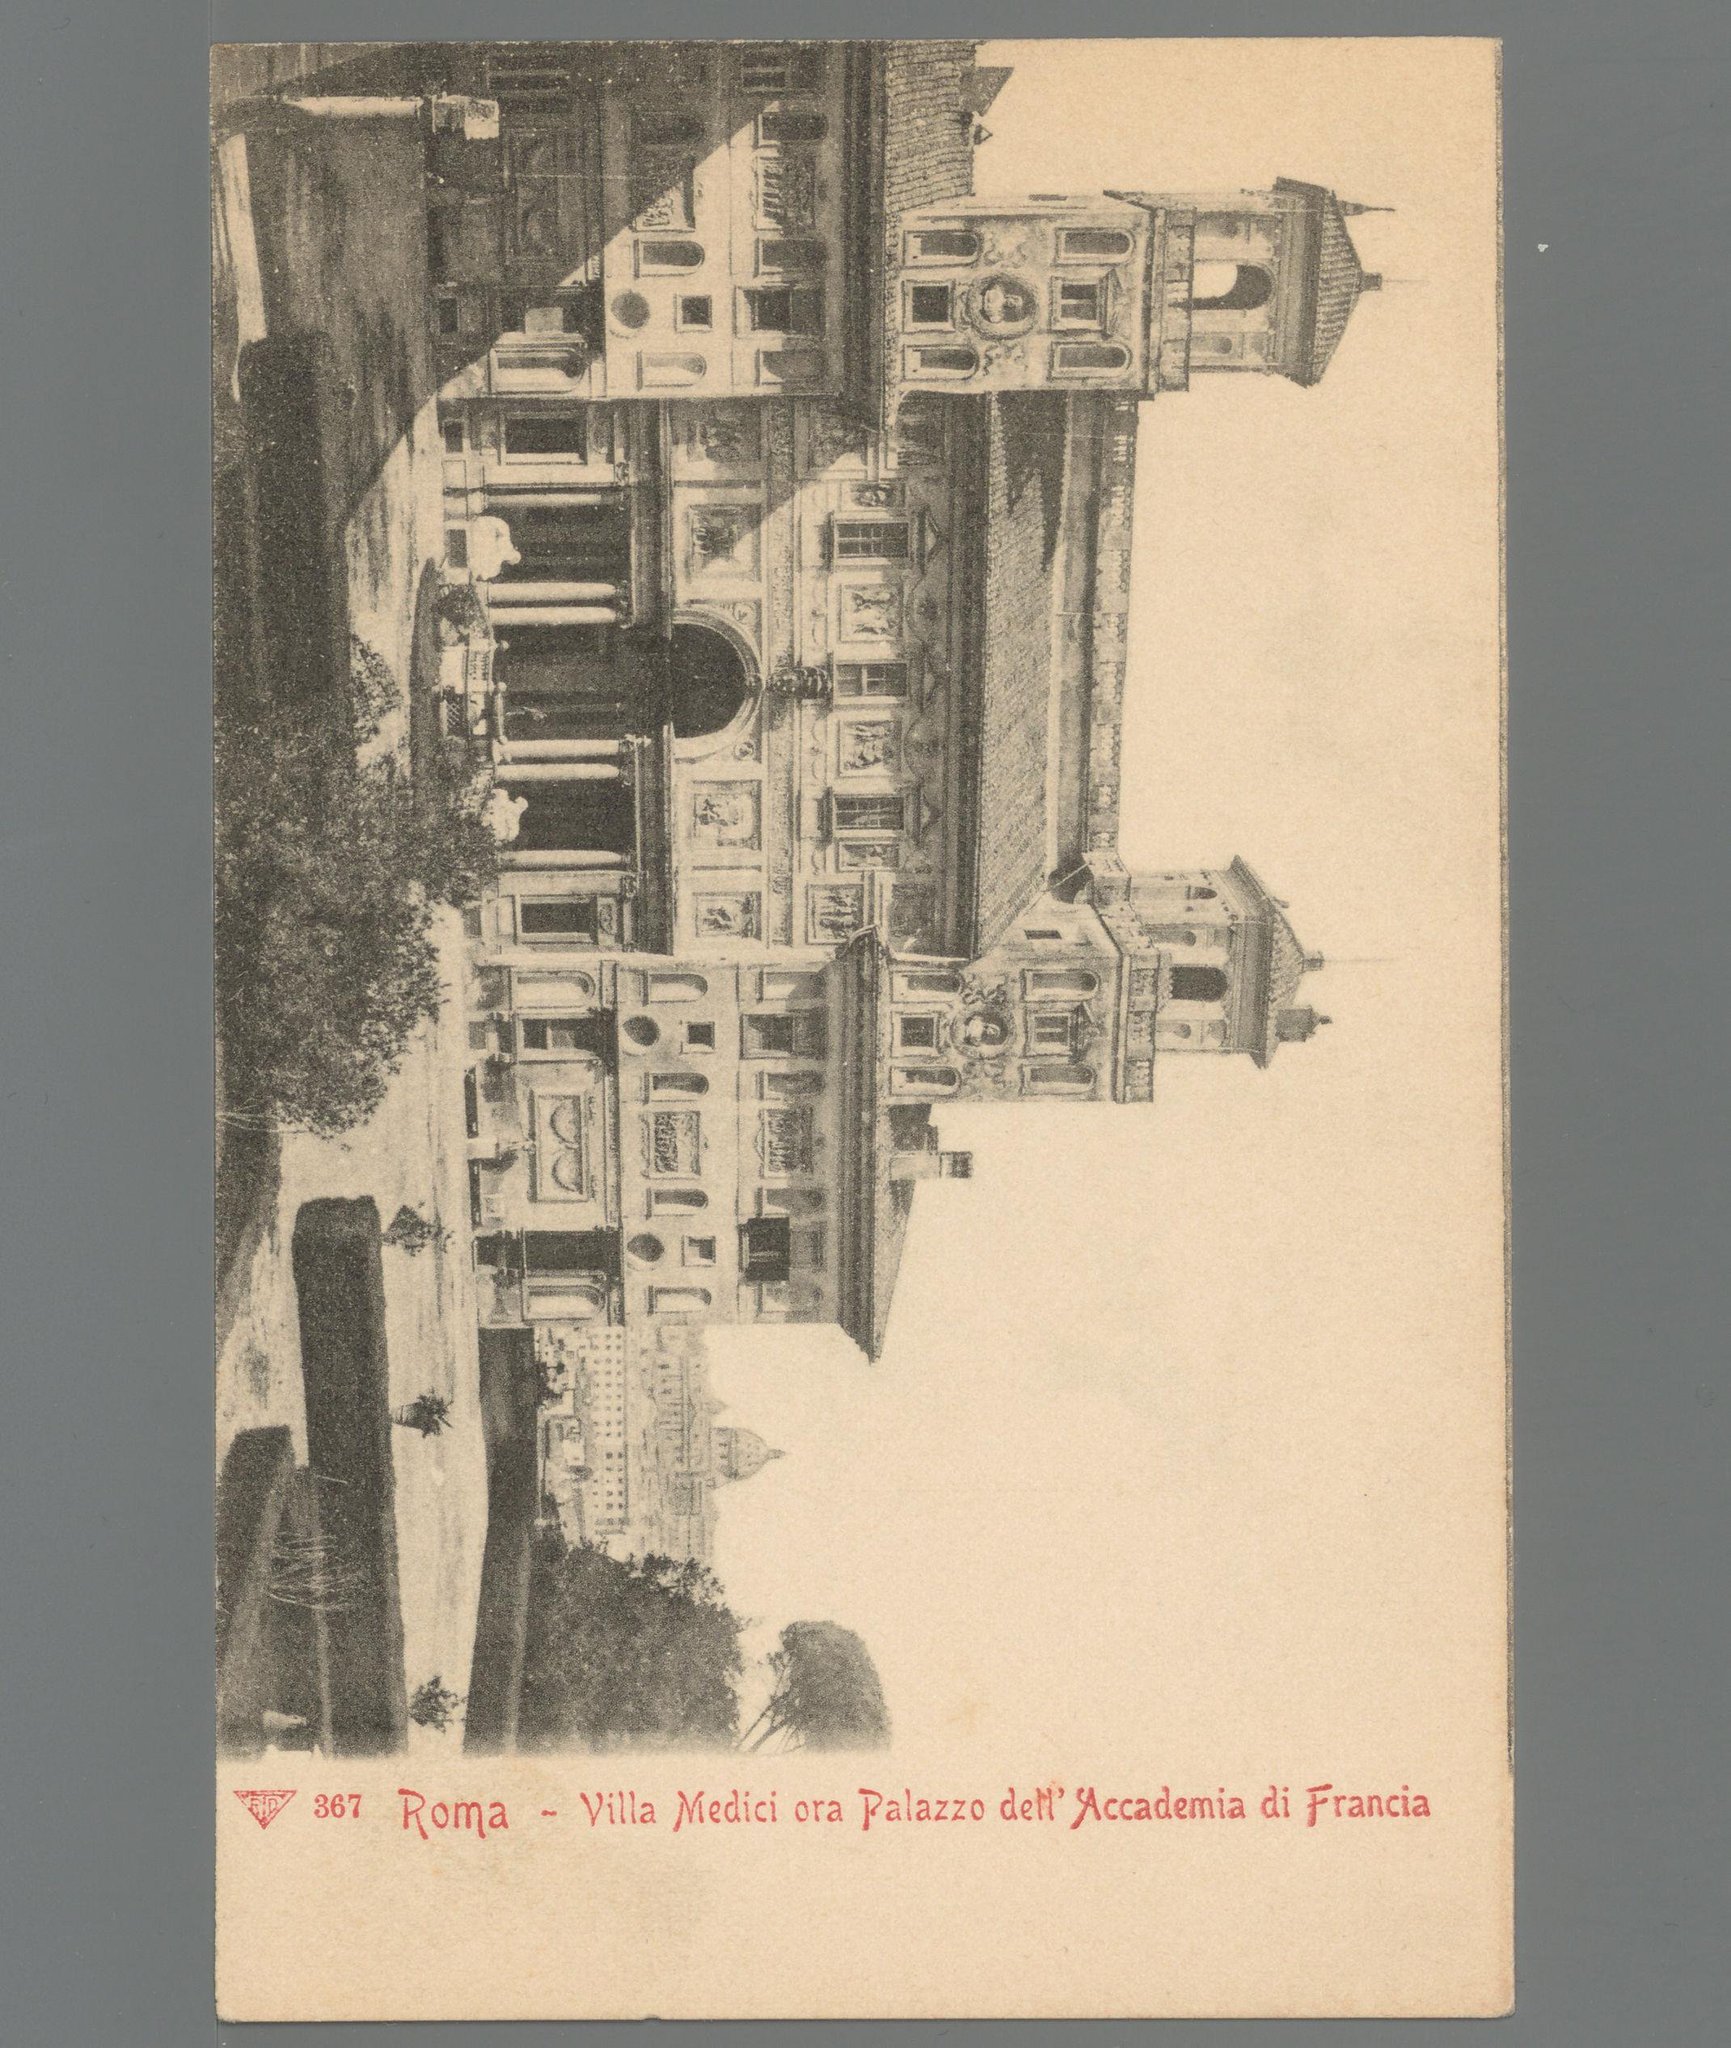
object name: photomechanical print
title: Roma. Villa Medici ora Palazzo dell'Accademia di Francia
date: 1889-1906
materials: cardboard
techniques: photograph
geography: rome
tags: city-view, and landscape with man-made constructions, garden, palace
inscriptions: mark: ‘RTD’